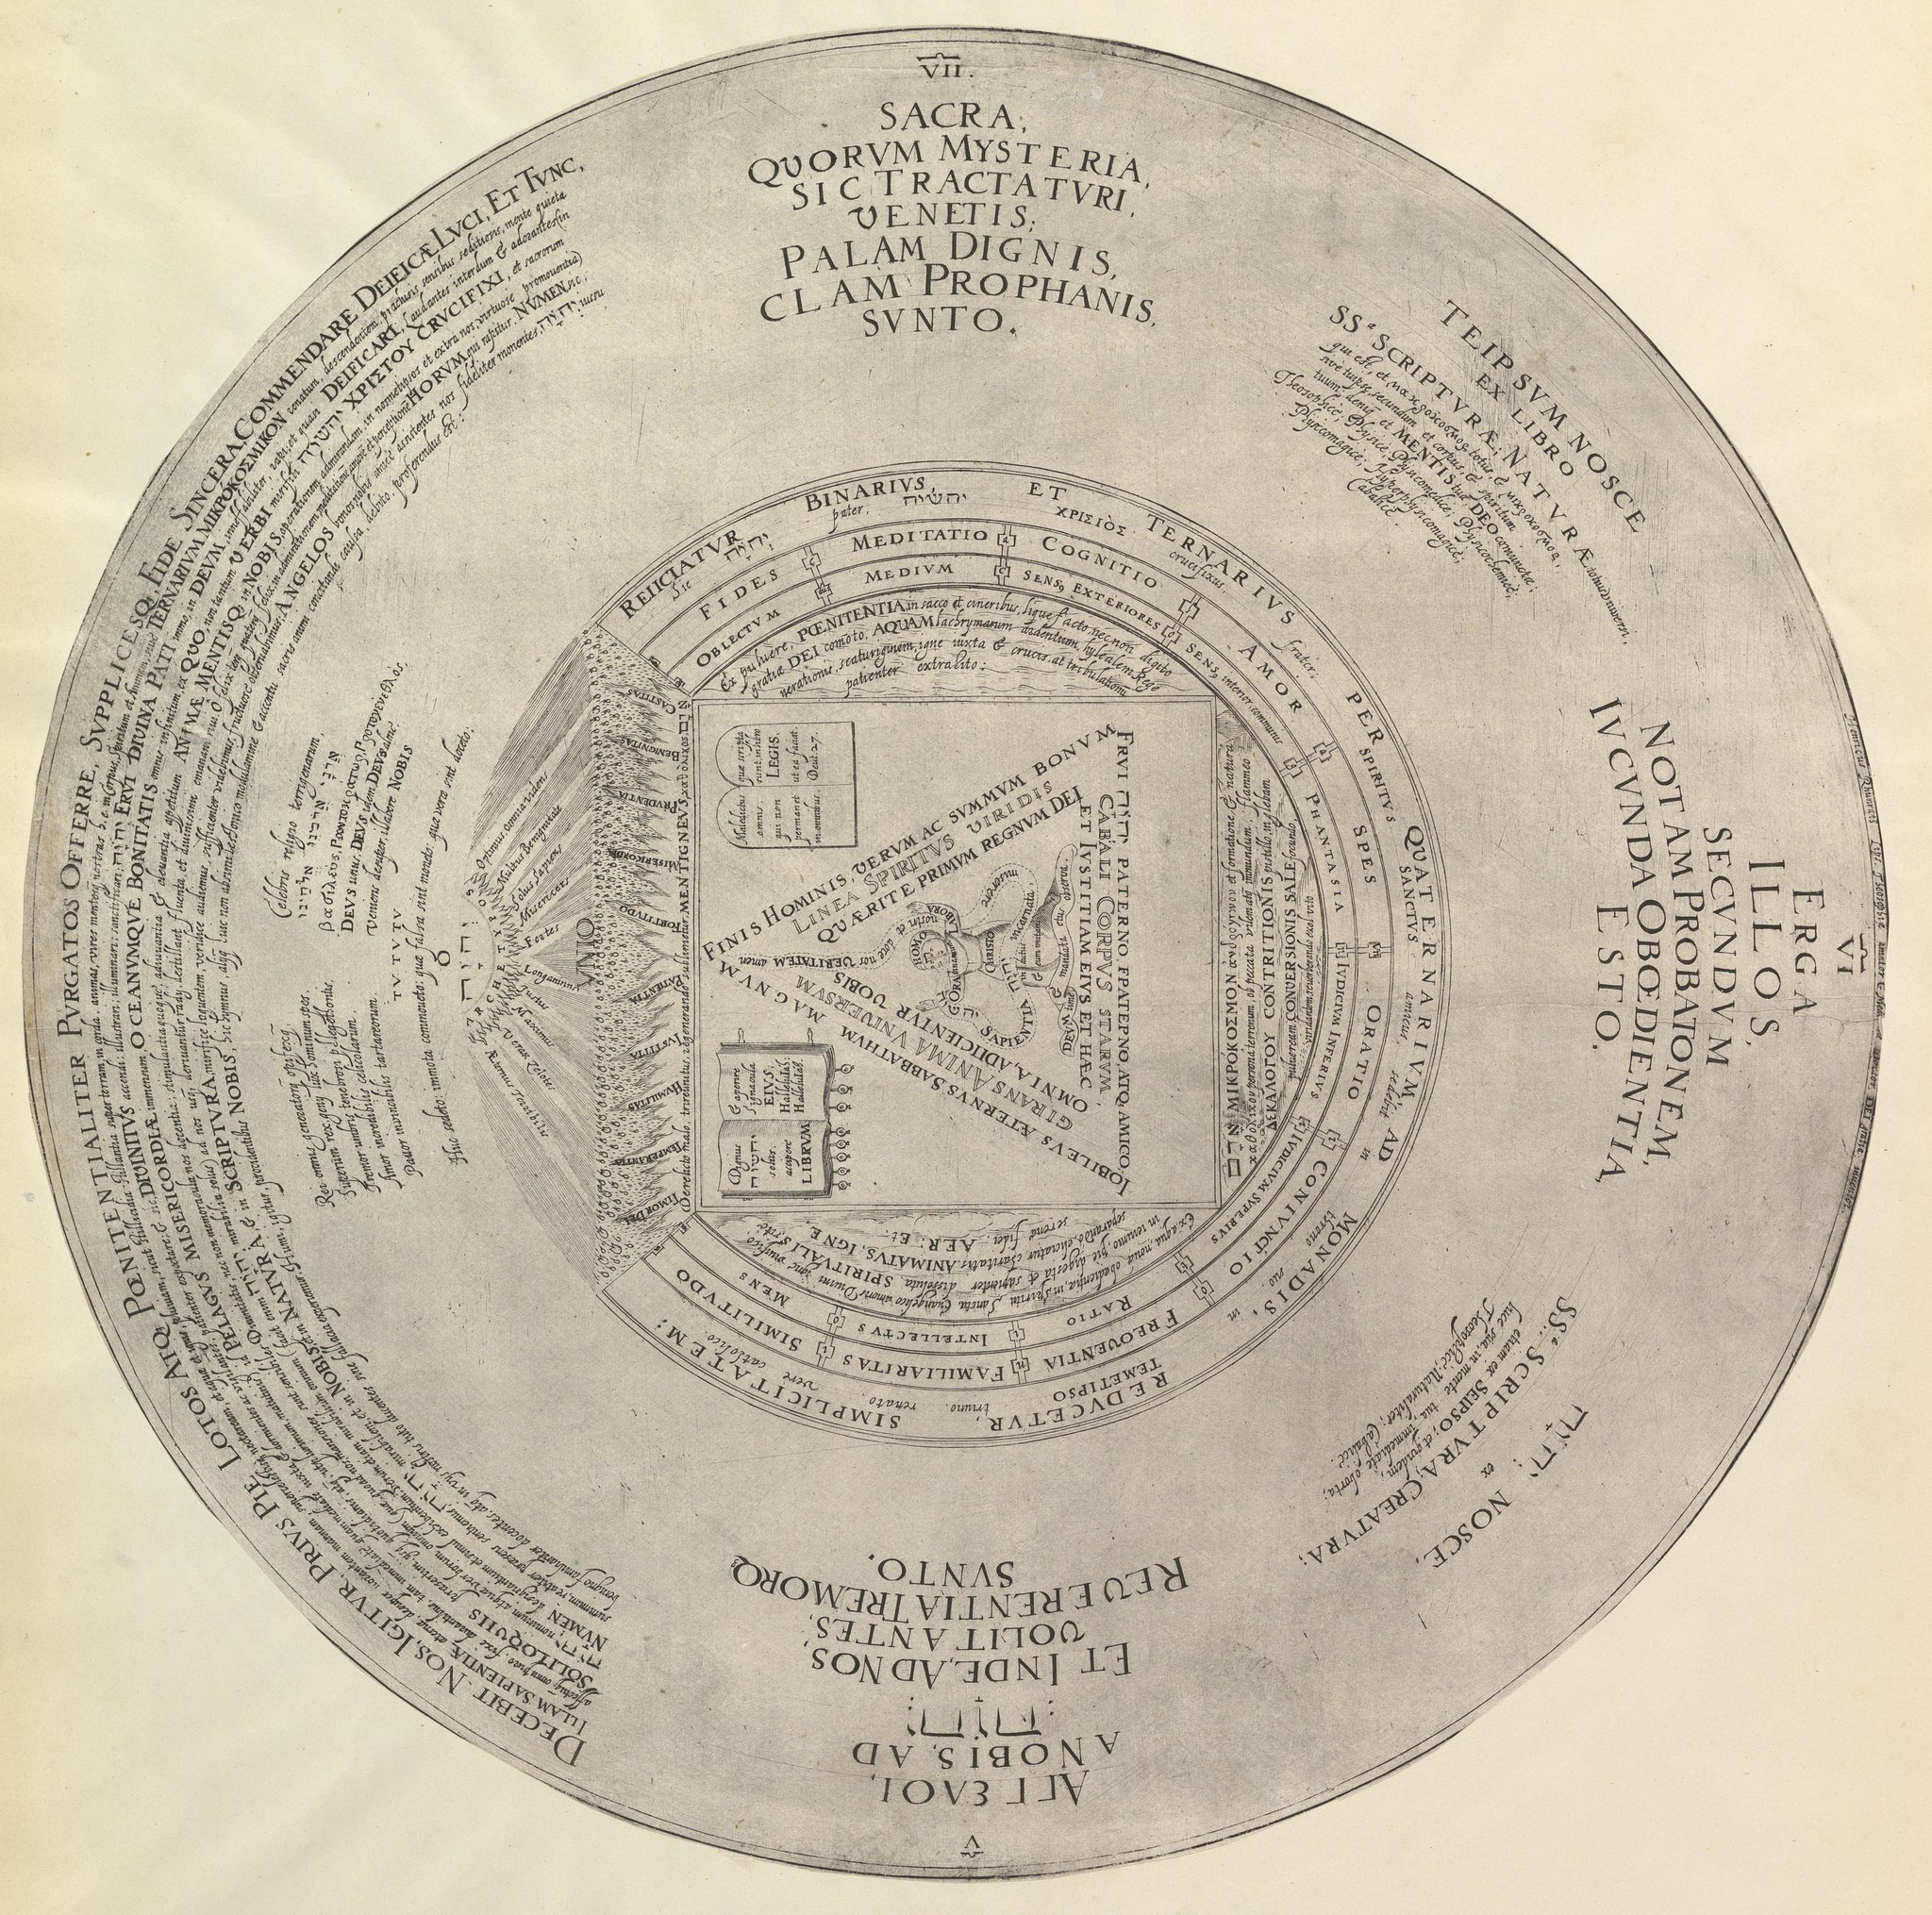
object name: print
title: Syzygy or the Conjunction of the Macrocosmic Unity with the Microcosmic Triunity from Heinrich Khunrath, Amphiteatrum sapientiae aeternae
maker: peter van der doort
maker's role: artist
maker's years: 1590-1605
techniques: engraving